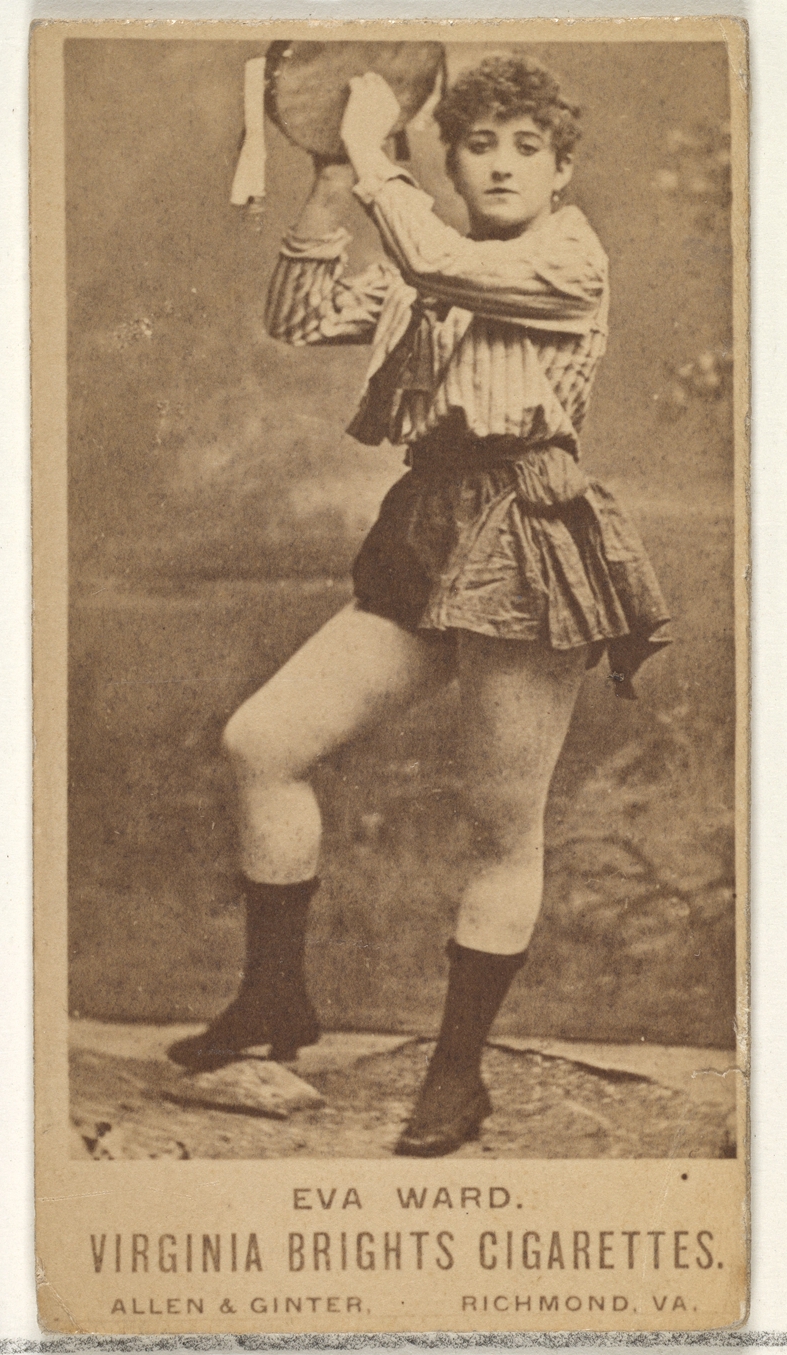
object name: photograph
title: Eva Ward, from the Actors and Actresses series (N45, Type 1) for Virginia Brights Cigarettes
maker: allen & ginter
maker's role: publisher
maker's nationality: american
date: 1888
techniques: albumen silver print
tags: portraits,women,actresses